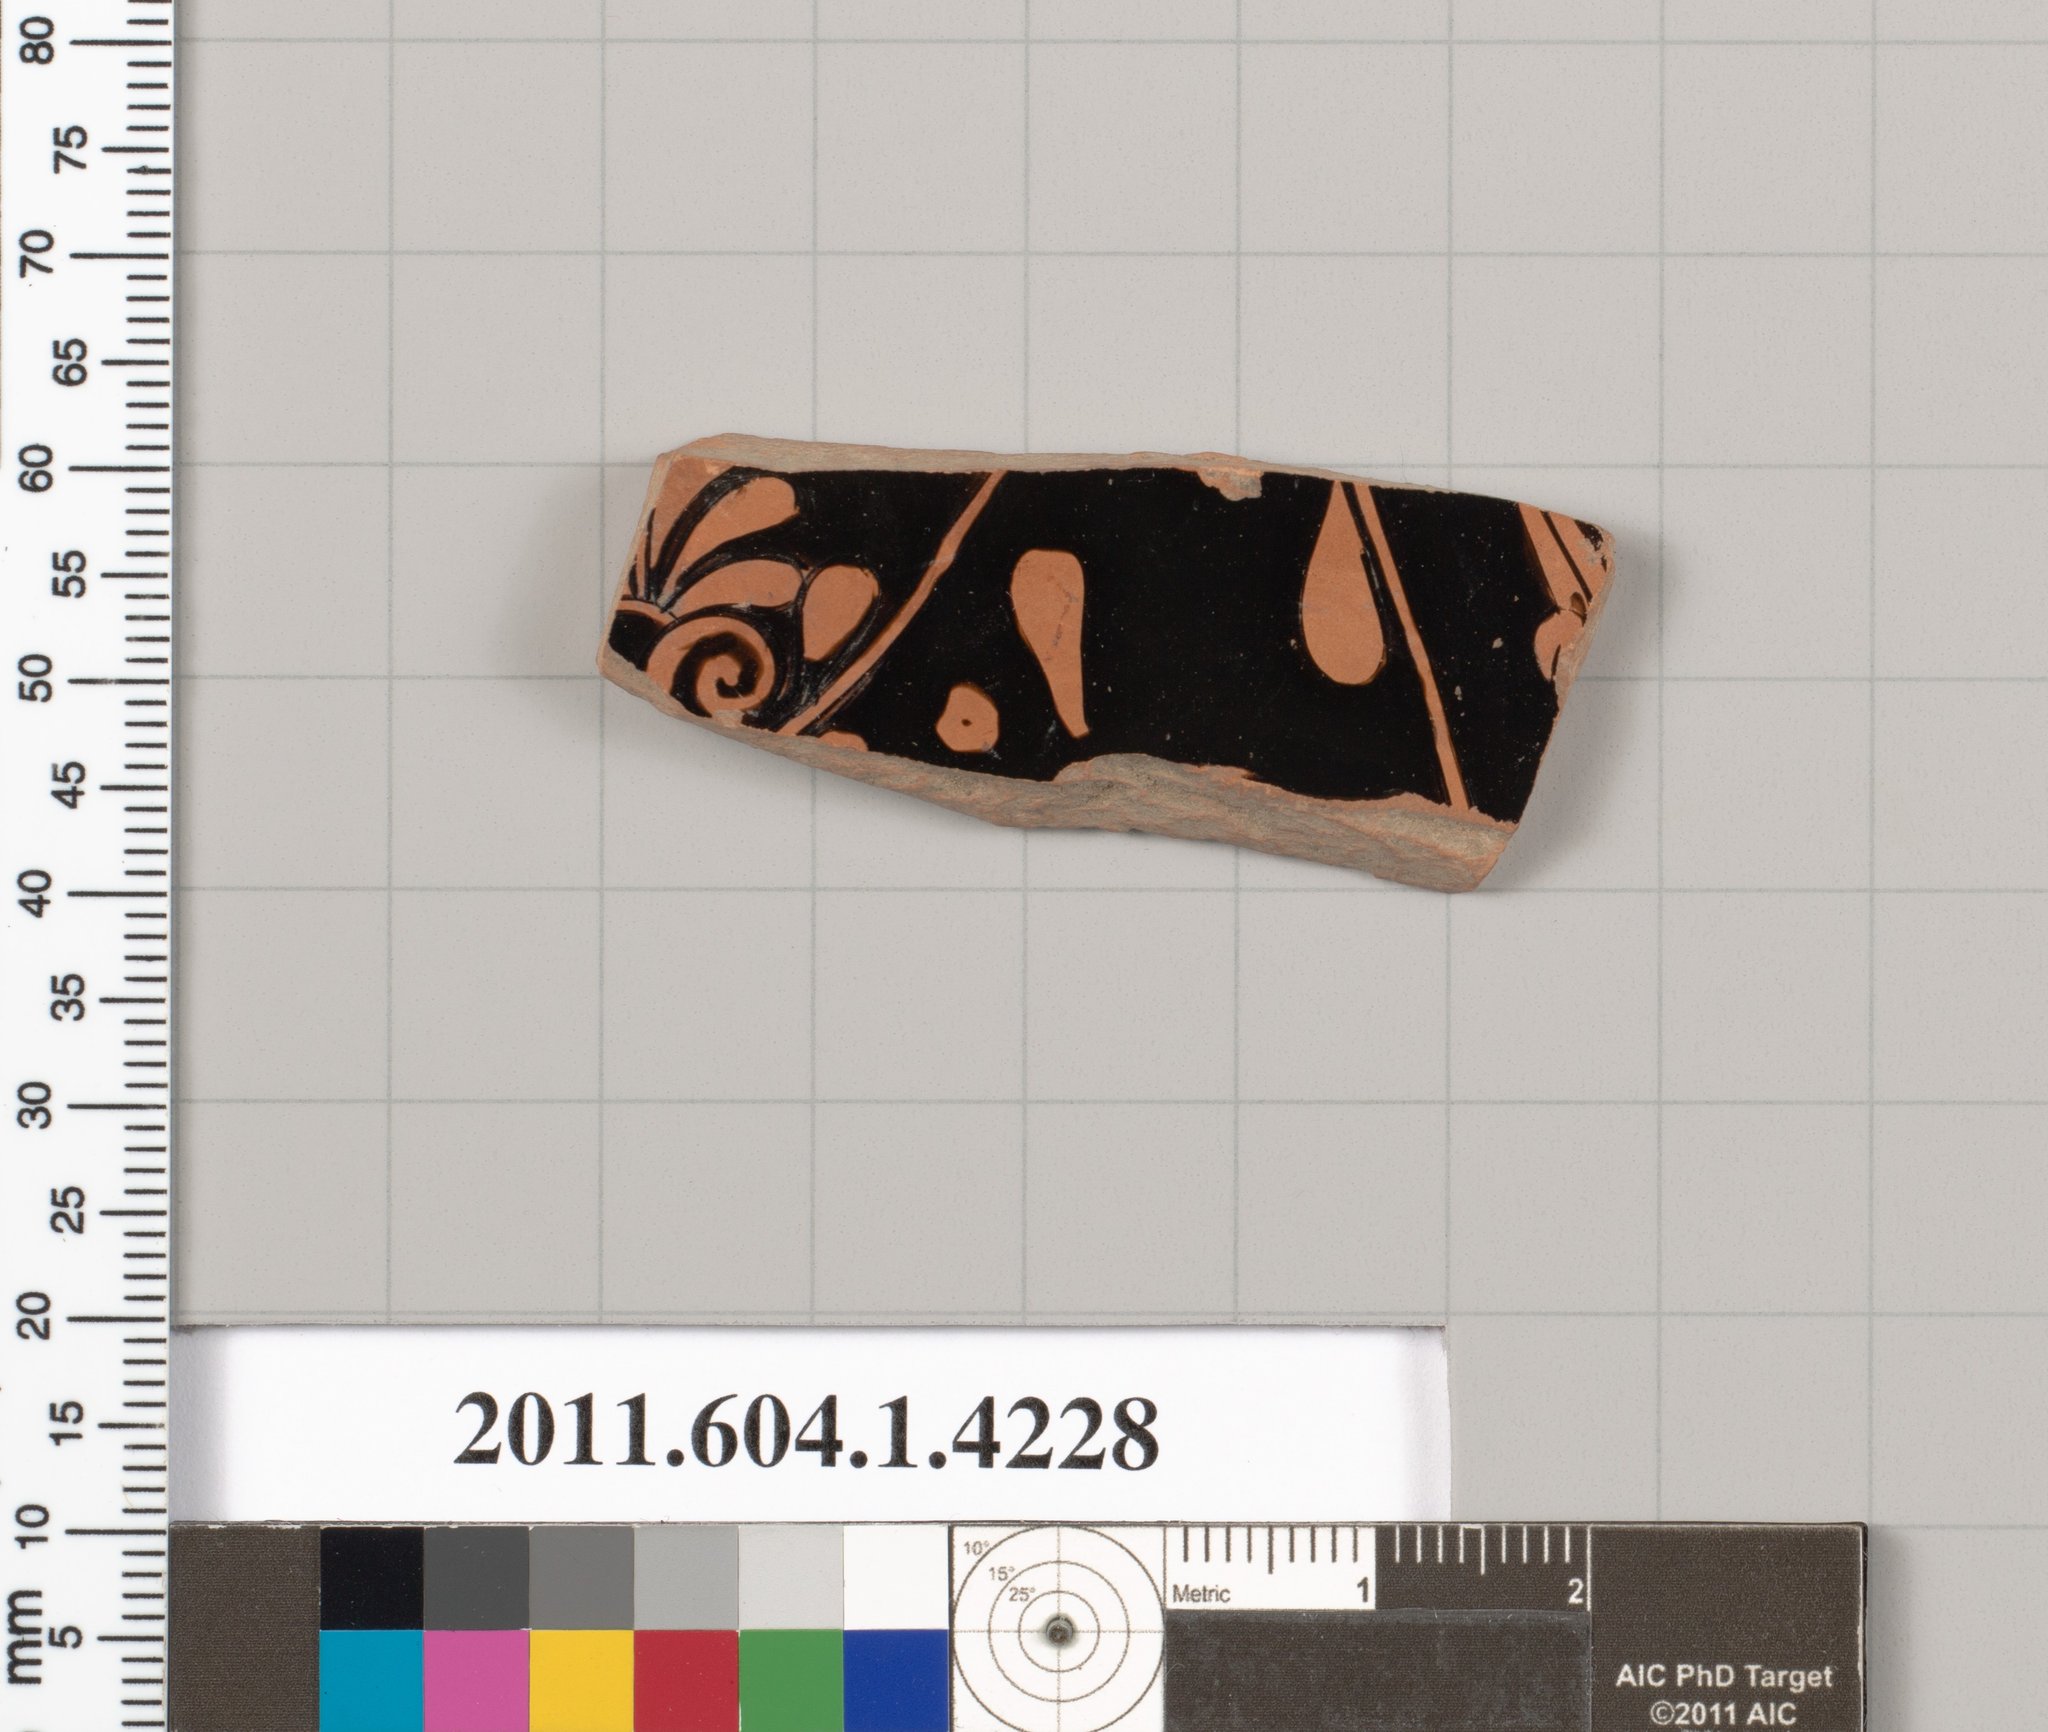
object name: kylix fragment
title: Terracotta fragment of a kylix (drinking cup)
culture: greek, attic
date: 500-480 BCE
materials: terracotta